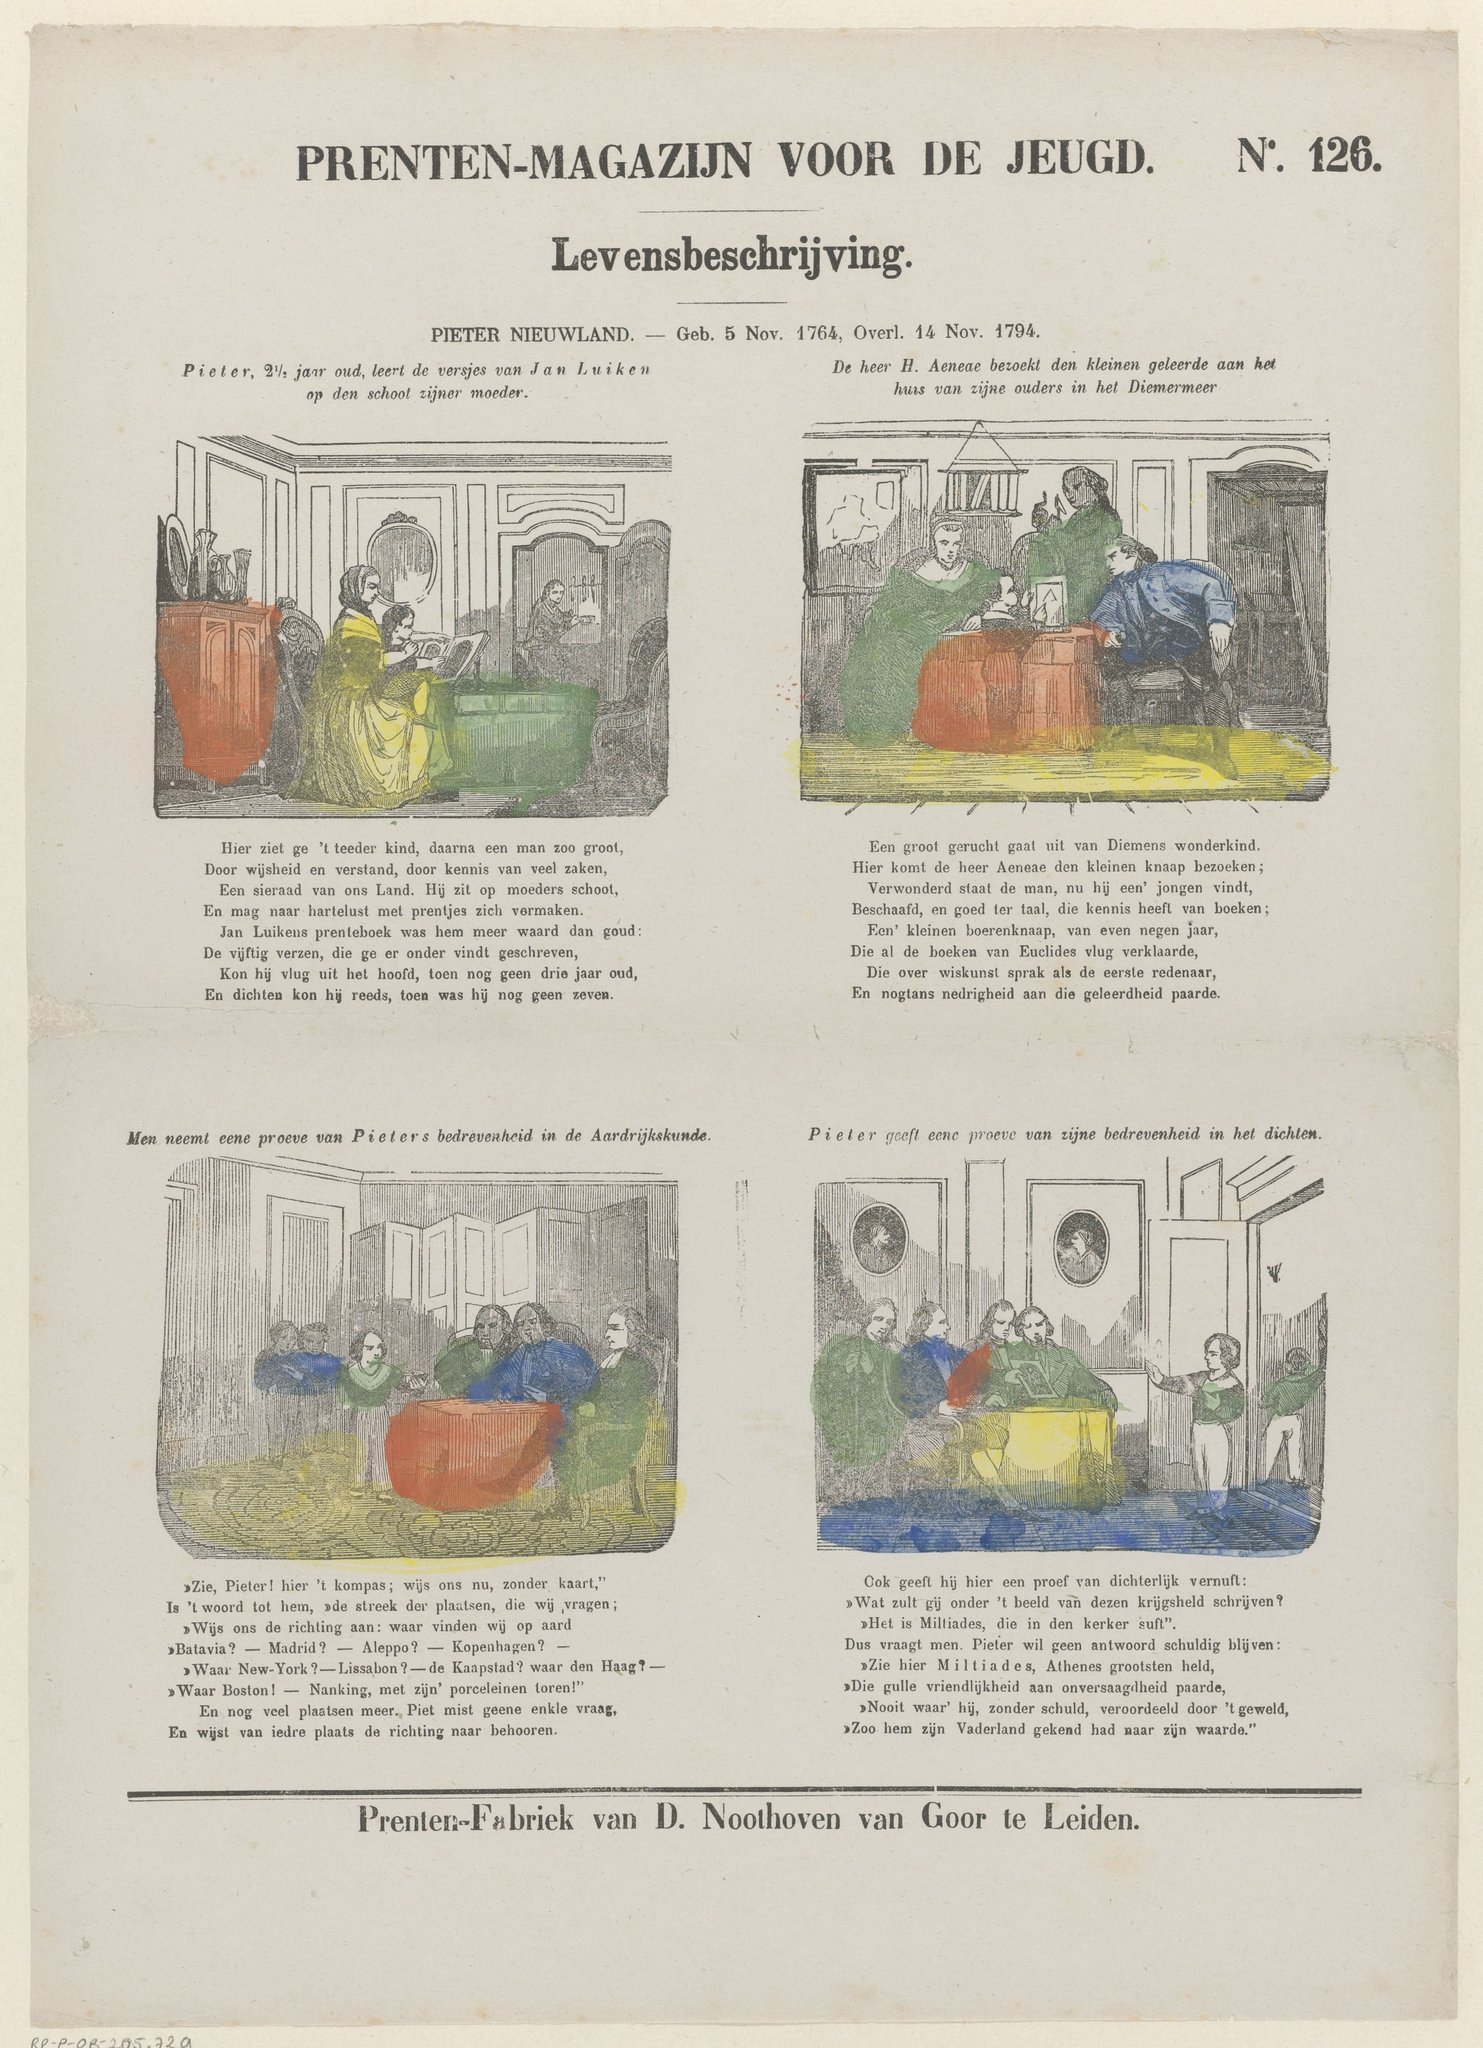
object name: print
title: Pieter Nieuwland. - Geb. 5 Nov. 1764, Overl. 14 Nov. 1794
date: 1850-1881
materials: paper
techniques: colour, letterpress printing, engraving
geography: netherlands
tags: hendrik aeneae, amsterdam, print maker, jan luyken, education, science and learning, child, historical persons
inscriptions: collector's mark: Lugt 2760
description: Blad met 4 voorstellingen uit het leven van Pieter Nieuwland. Boven elke afbeelding een titel, onder elke afbeelding een achtregelig vers. Genummerd rechtsboven: No. 126.